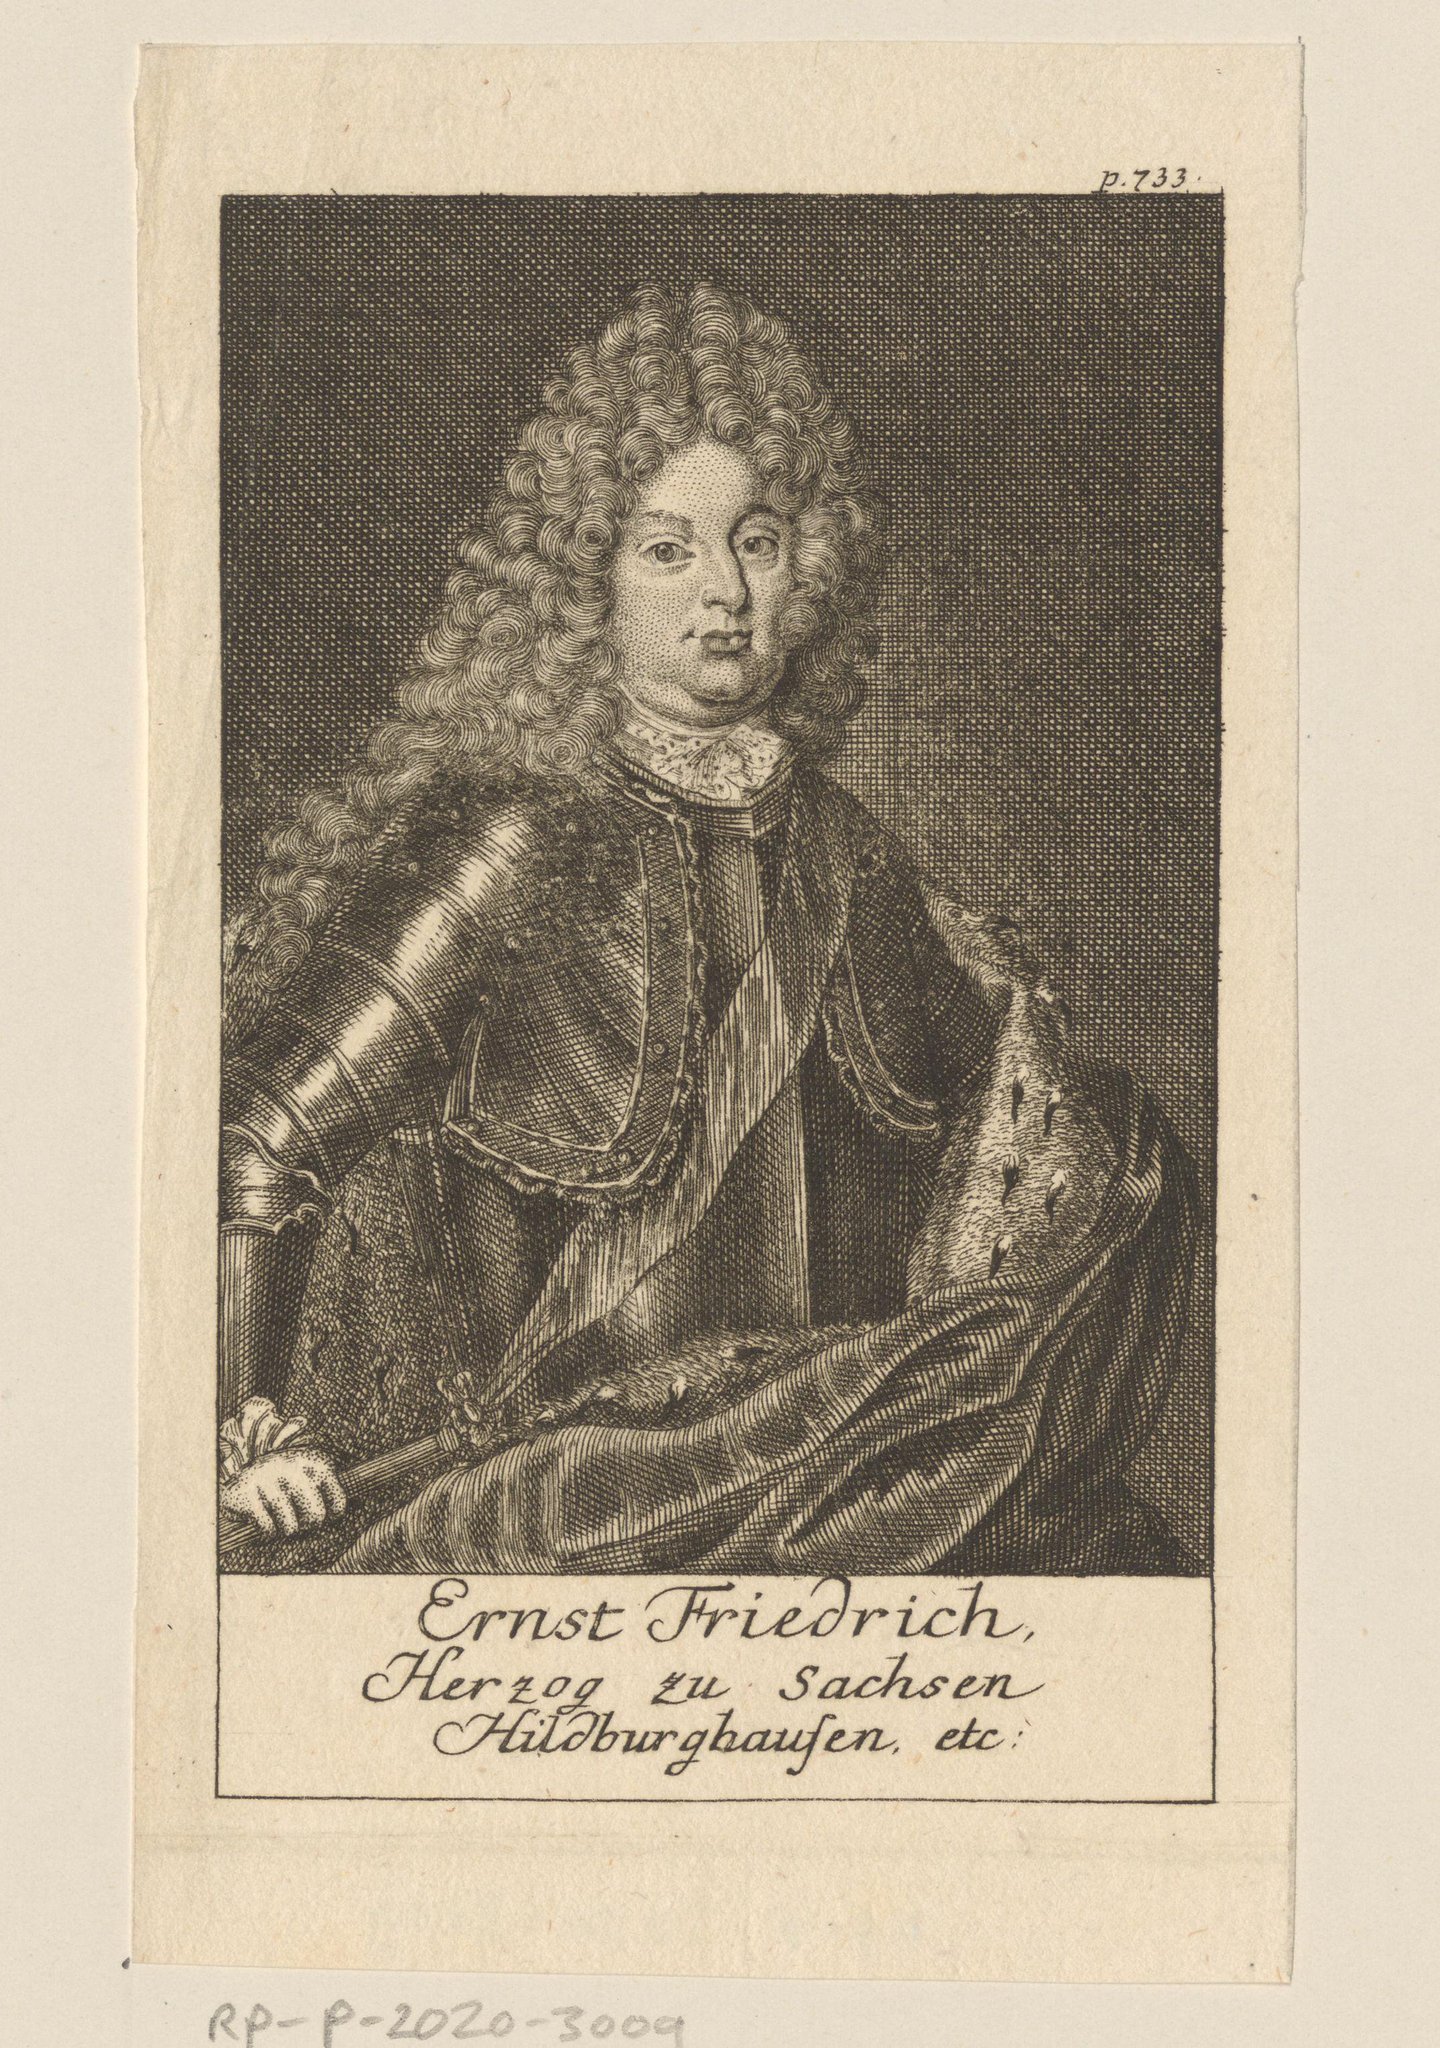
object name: print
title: Portret van Ernst Frederik I van Saksen-Hildburghausen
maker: Anonymous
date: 1715-1750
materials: paper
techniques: engraving, etching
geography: germany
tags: earl, ernst frederik i van saksen-hildburghausen, armour, historical persons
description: Prent komt uit een onbekende publicatie.